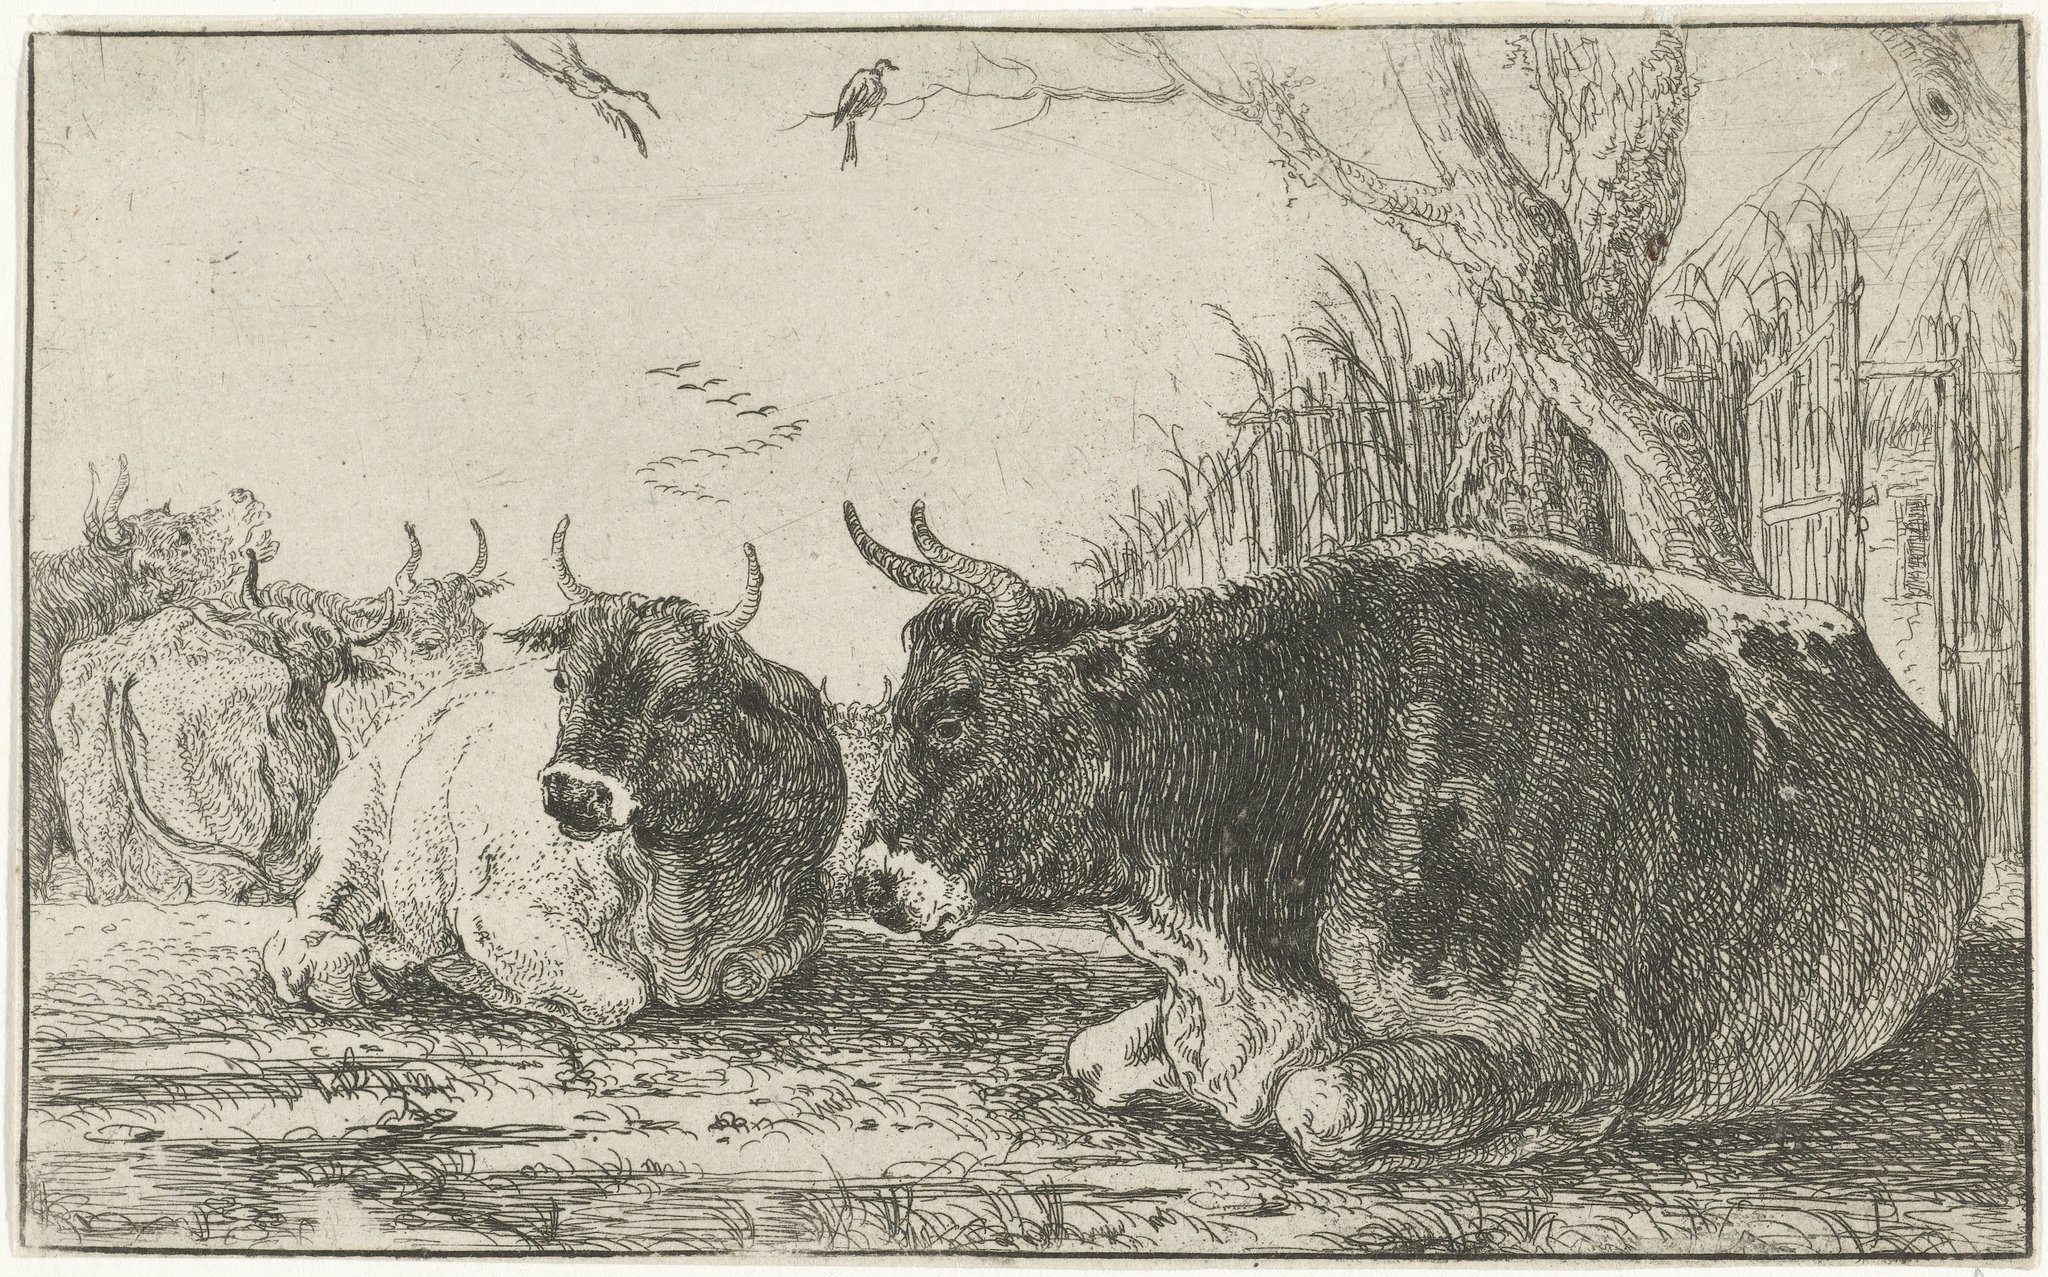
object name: print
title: Dieren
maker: jan van den hecke (i)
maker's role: print maker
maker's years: 1619-1684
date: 1656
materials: paper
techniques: etching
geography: brussels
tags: cow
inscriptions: collector's mark: Lugt 913, collector's mark: Lugt 2228